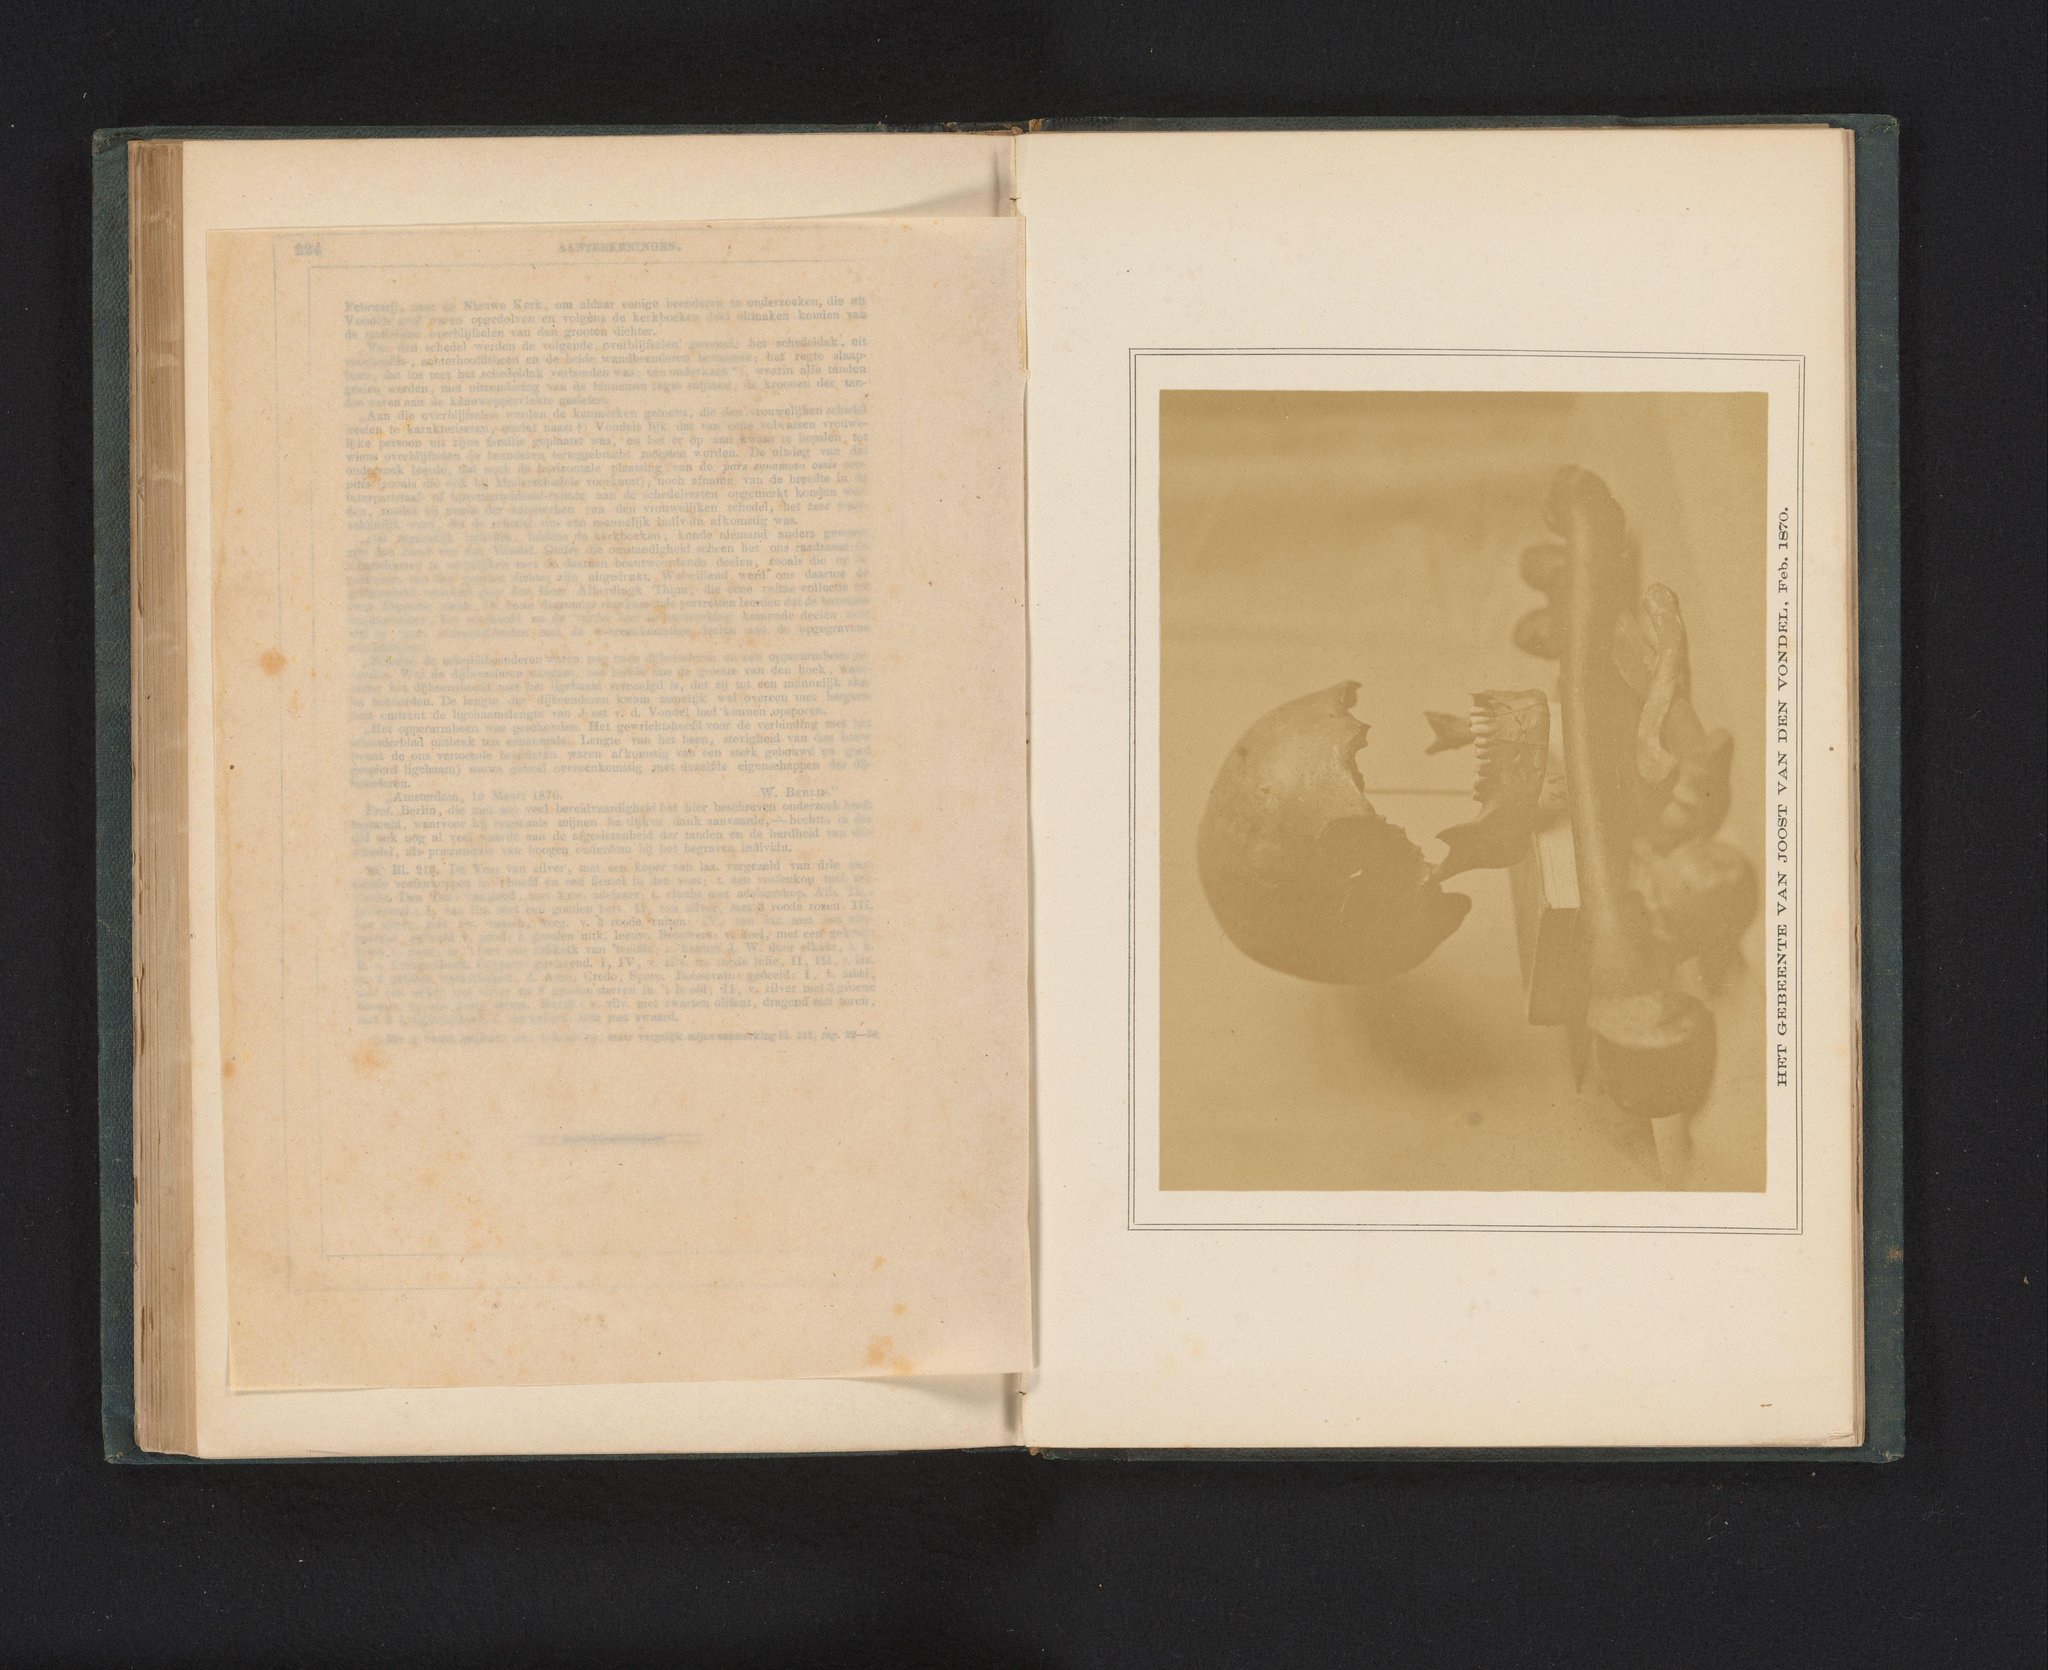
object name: page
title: Het gebeente van Joost van den Vondel, Feb. 1870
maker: p. oosterhuis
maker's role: fotograaf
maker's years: 1816-1885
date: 1802-1870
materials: photographic support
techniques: albumen print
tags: (human) skull, (human) skeleton